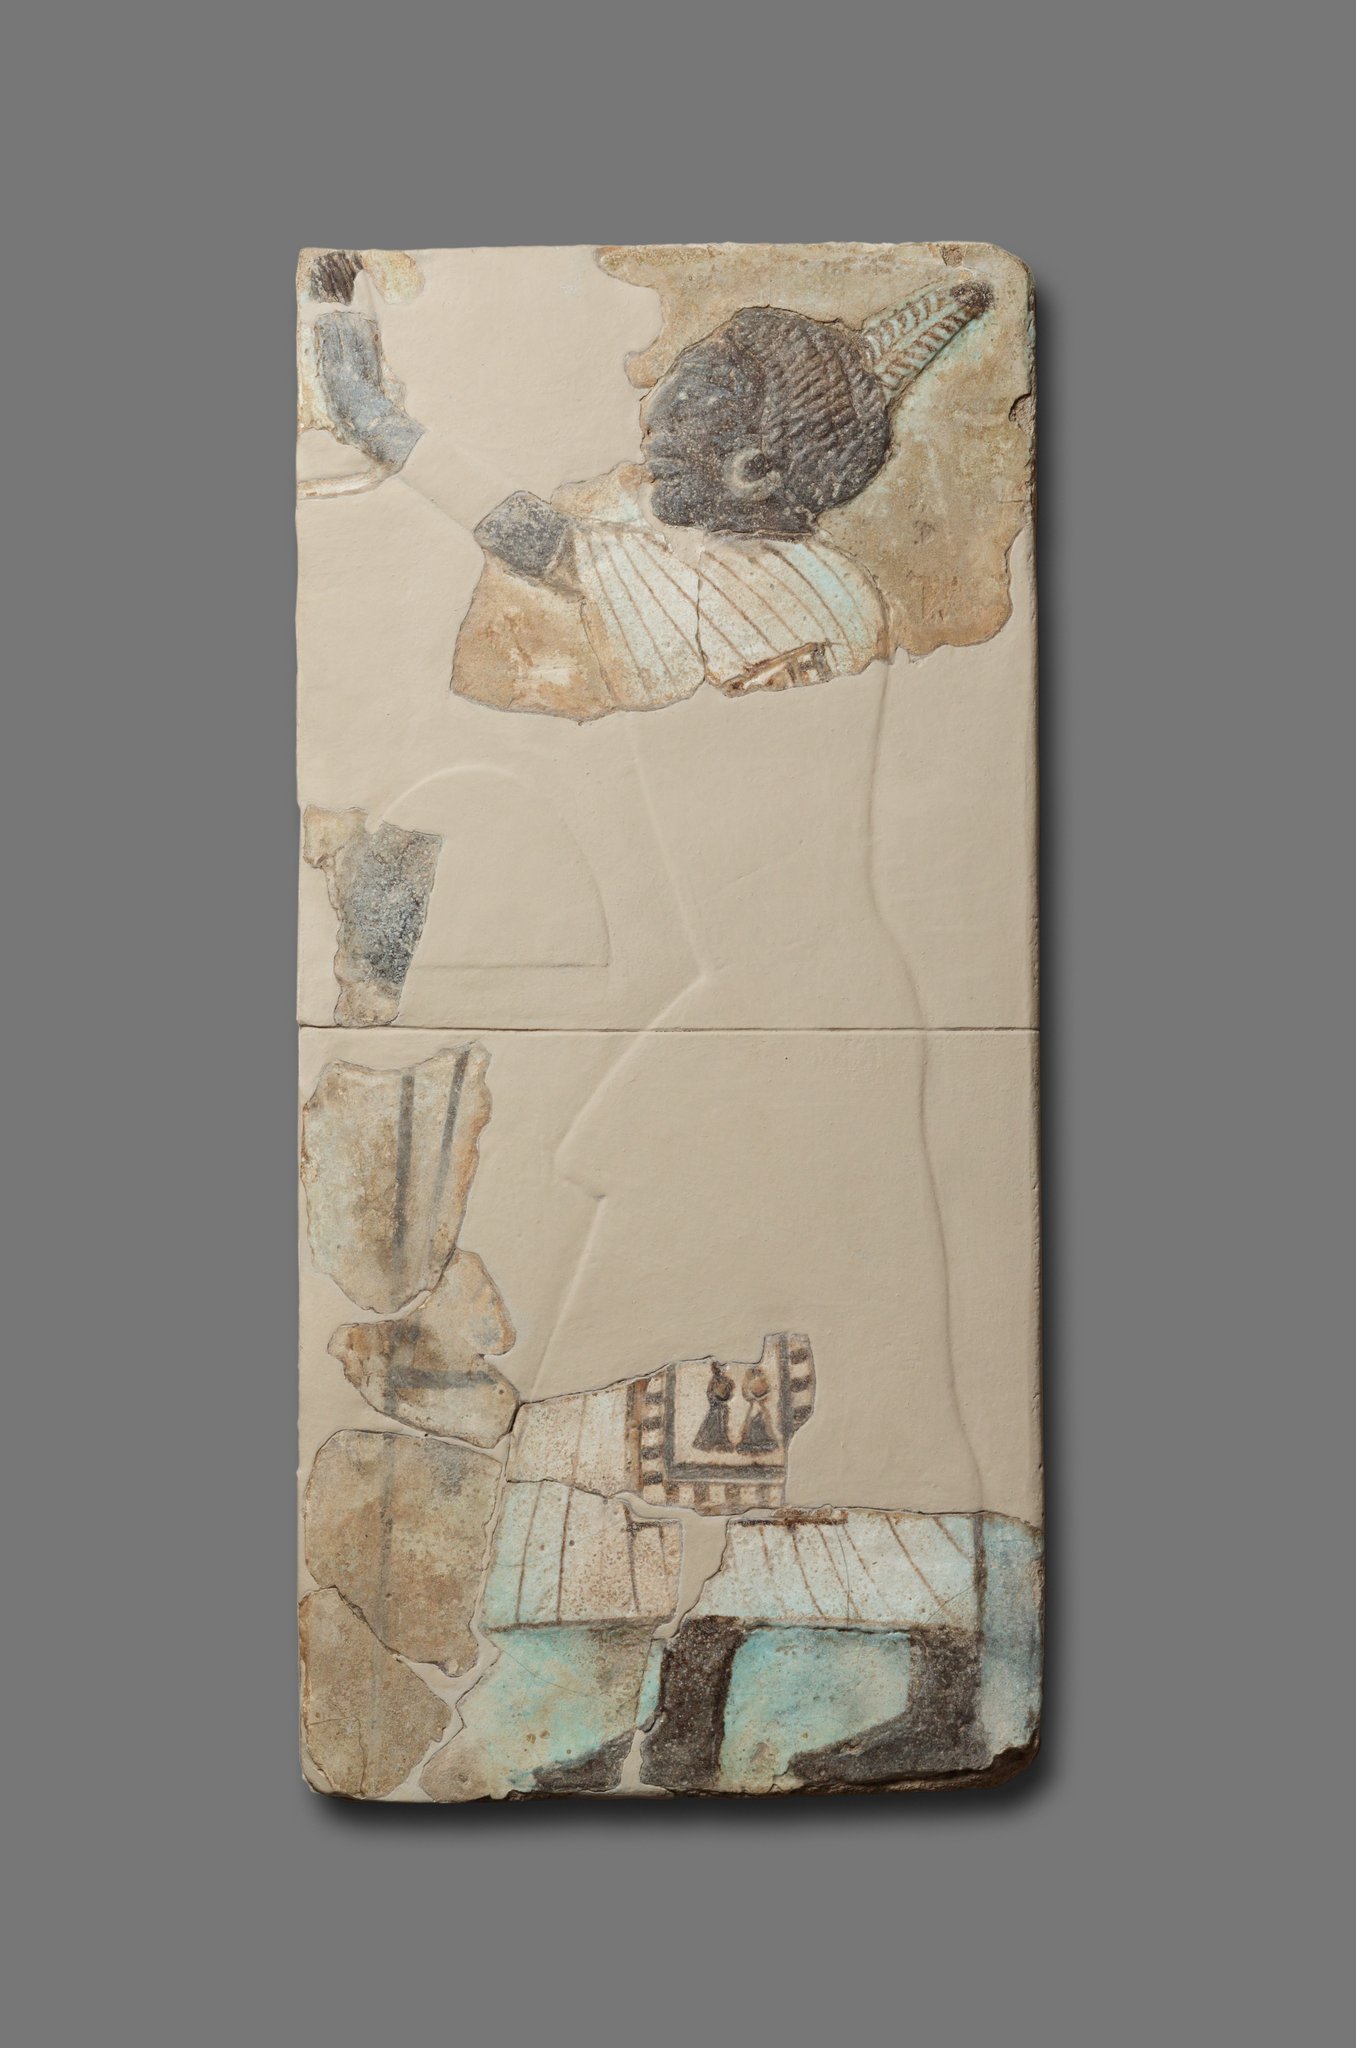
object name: tile inlay, palace of ramesses ii, foreigner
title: Tile from the walls of Throne Room in Palace of Ramesses II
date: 1279-1213 BCE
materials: faience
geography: egypt